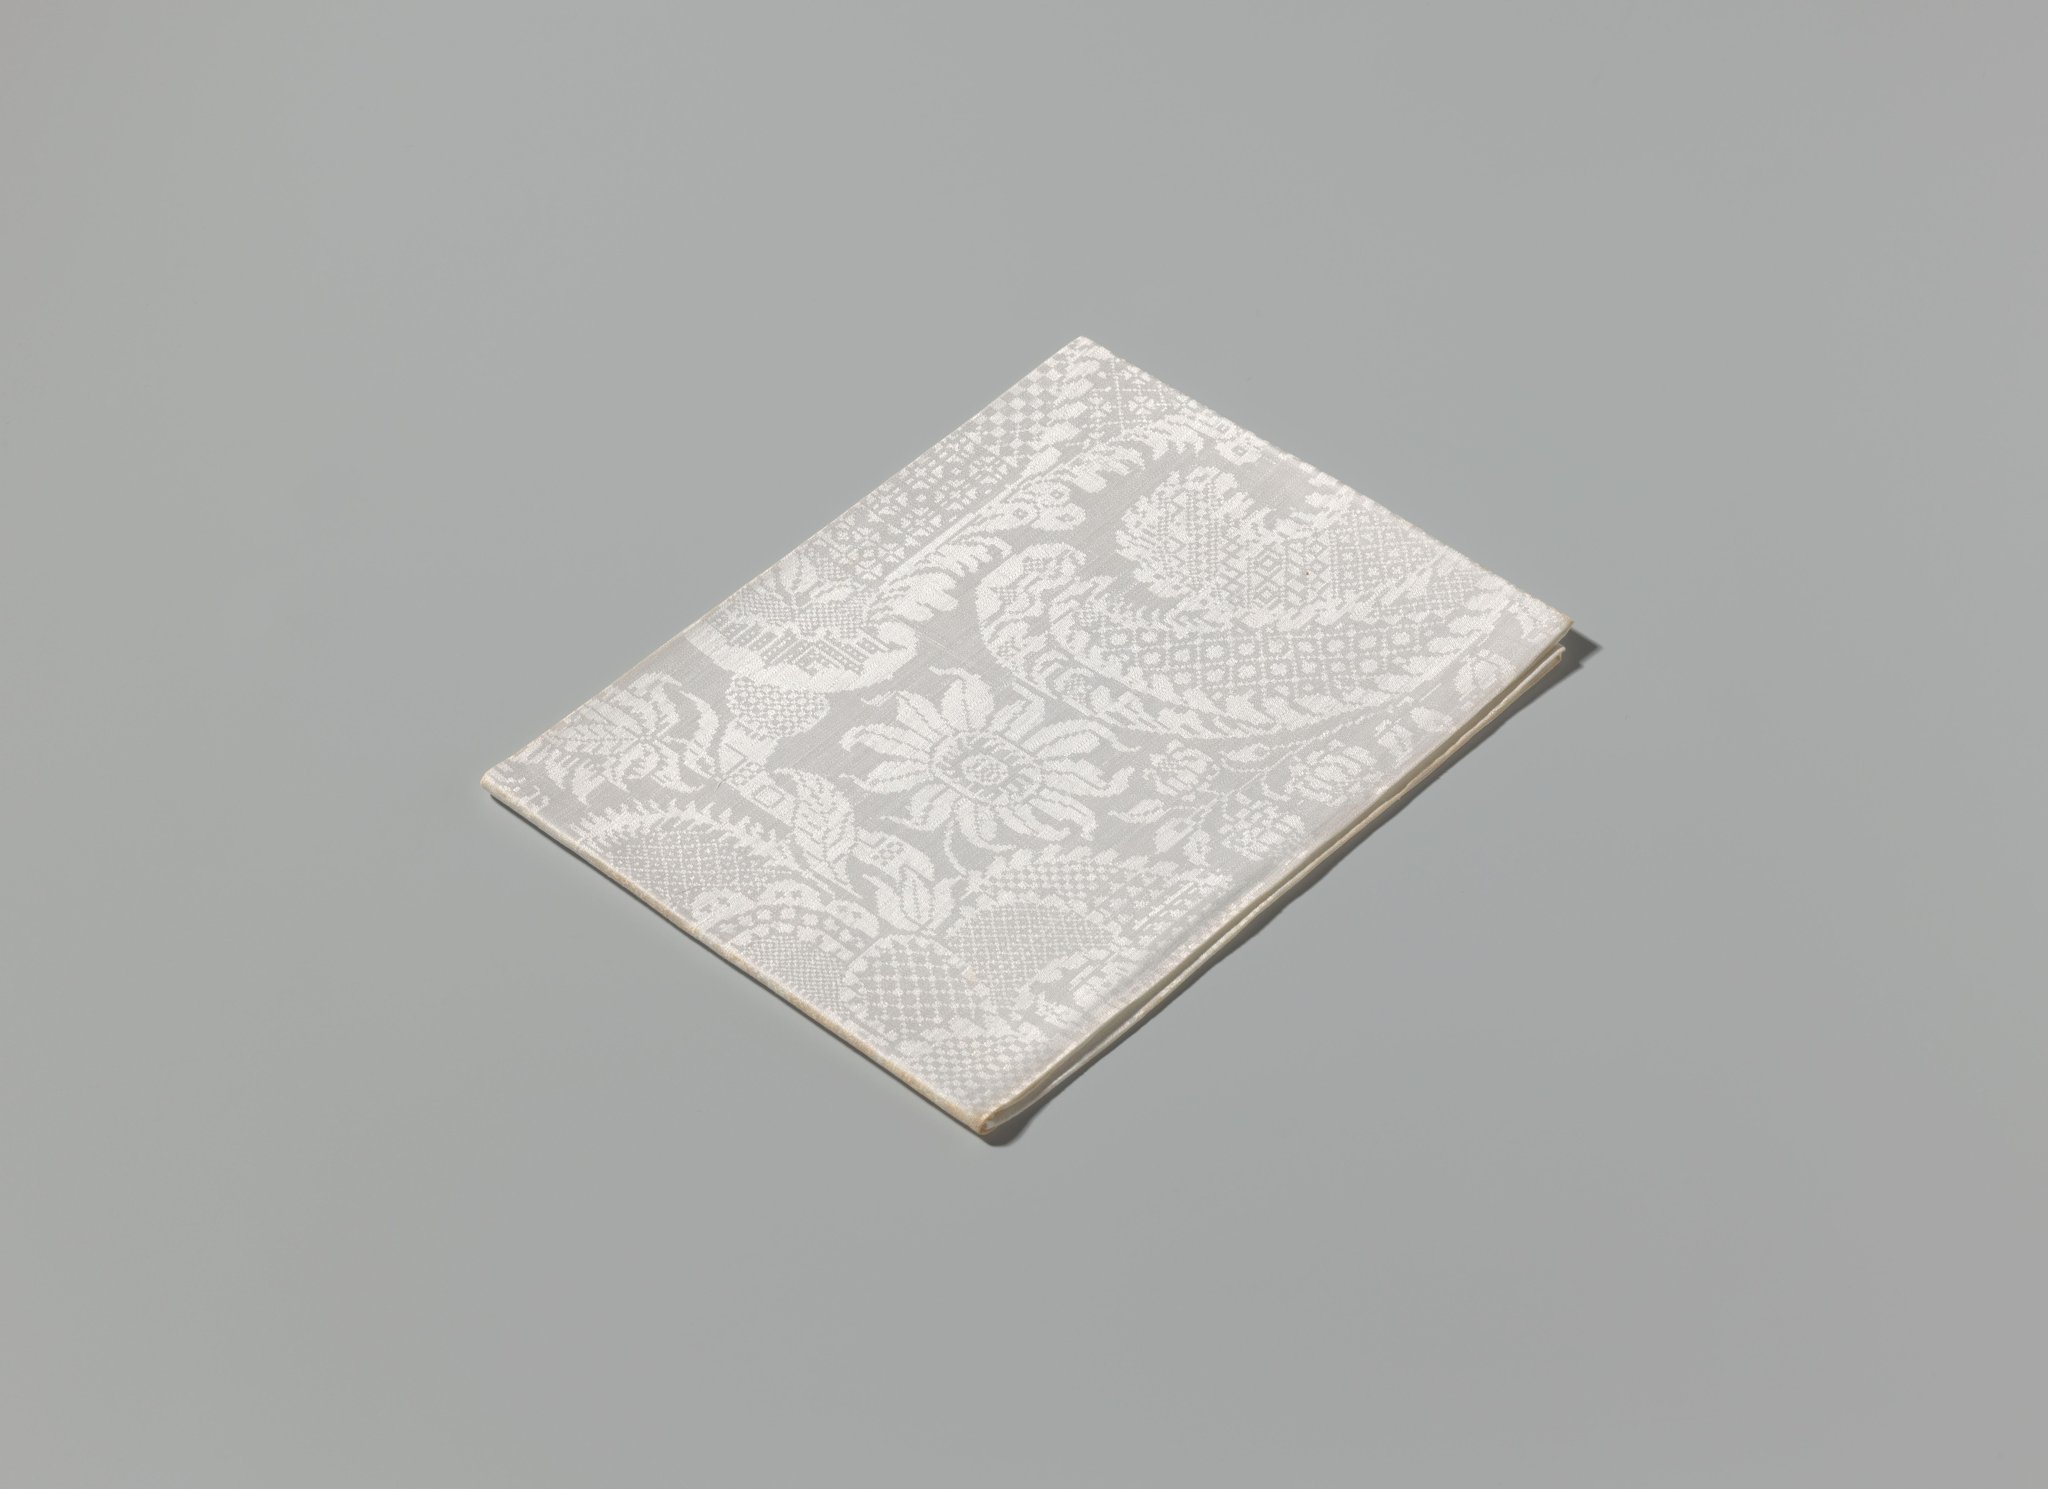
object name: napkin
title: Servet van linnendamast met een voluutpatroon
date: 1723-1730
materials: linen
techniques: damask, weave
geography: northern netherlands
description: Wit linnendamasten servet met patroon van voluten, merk: kroon WG 26.